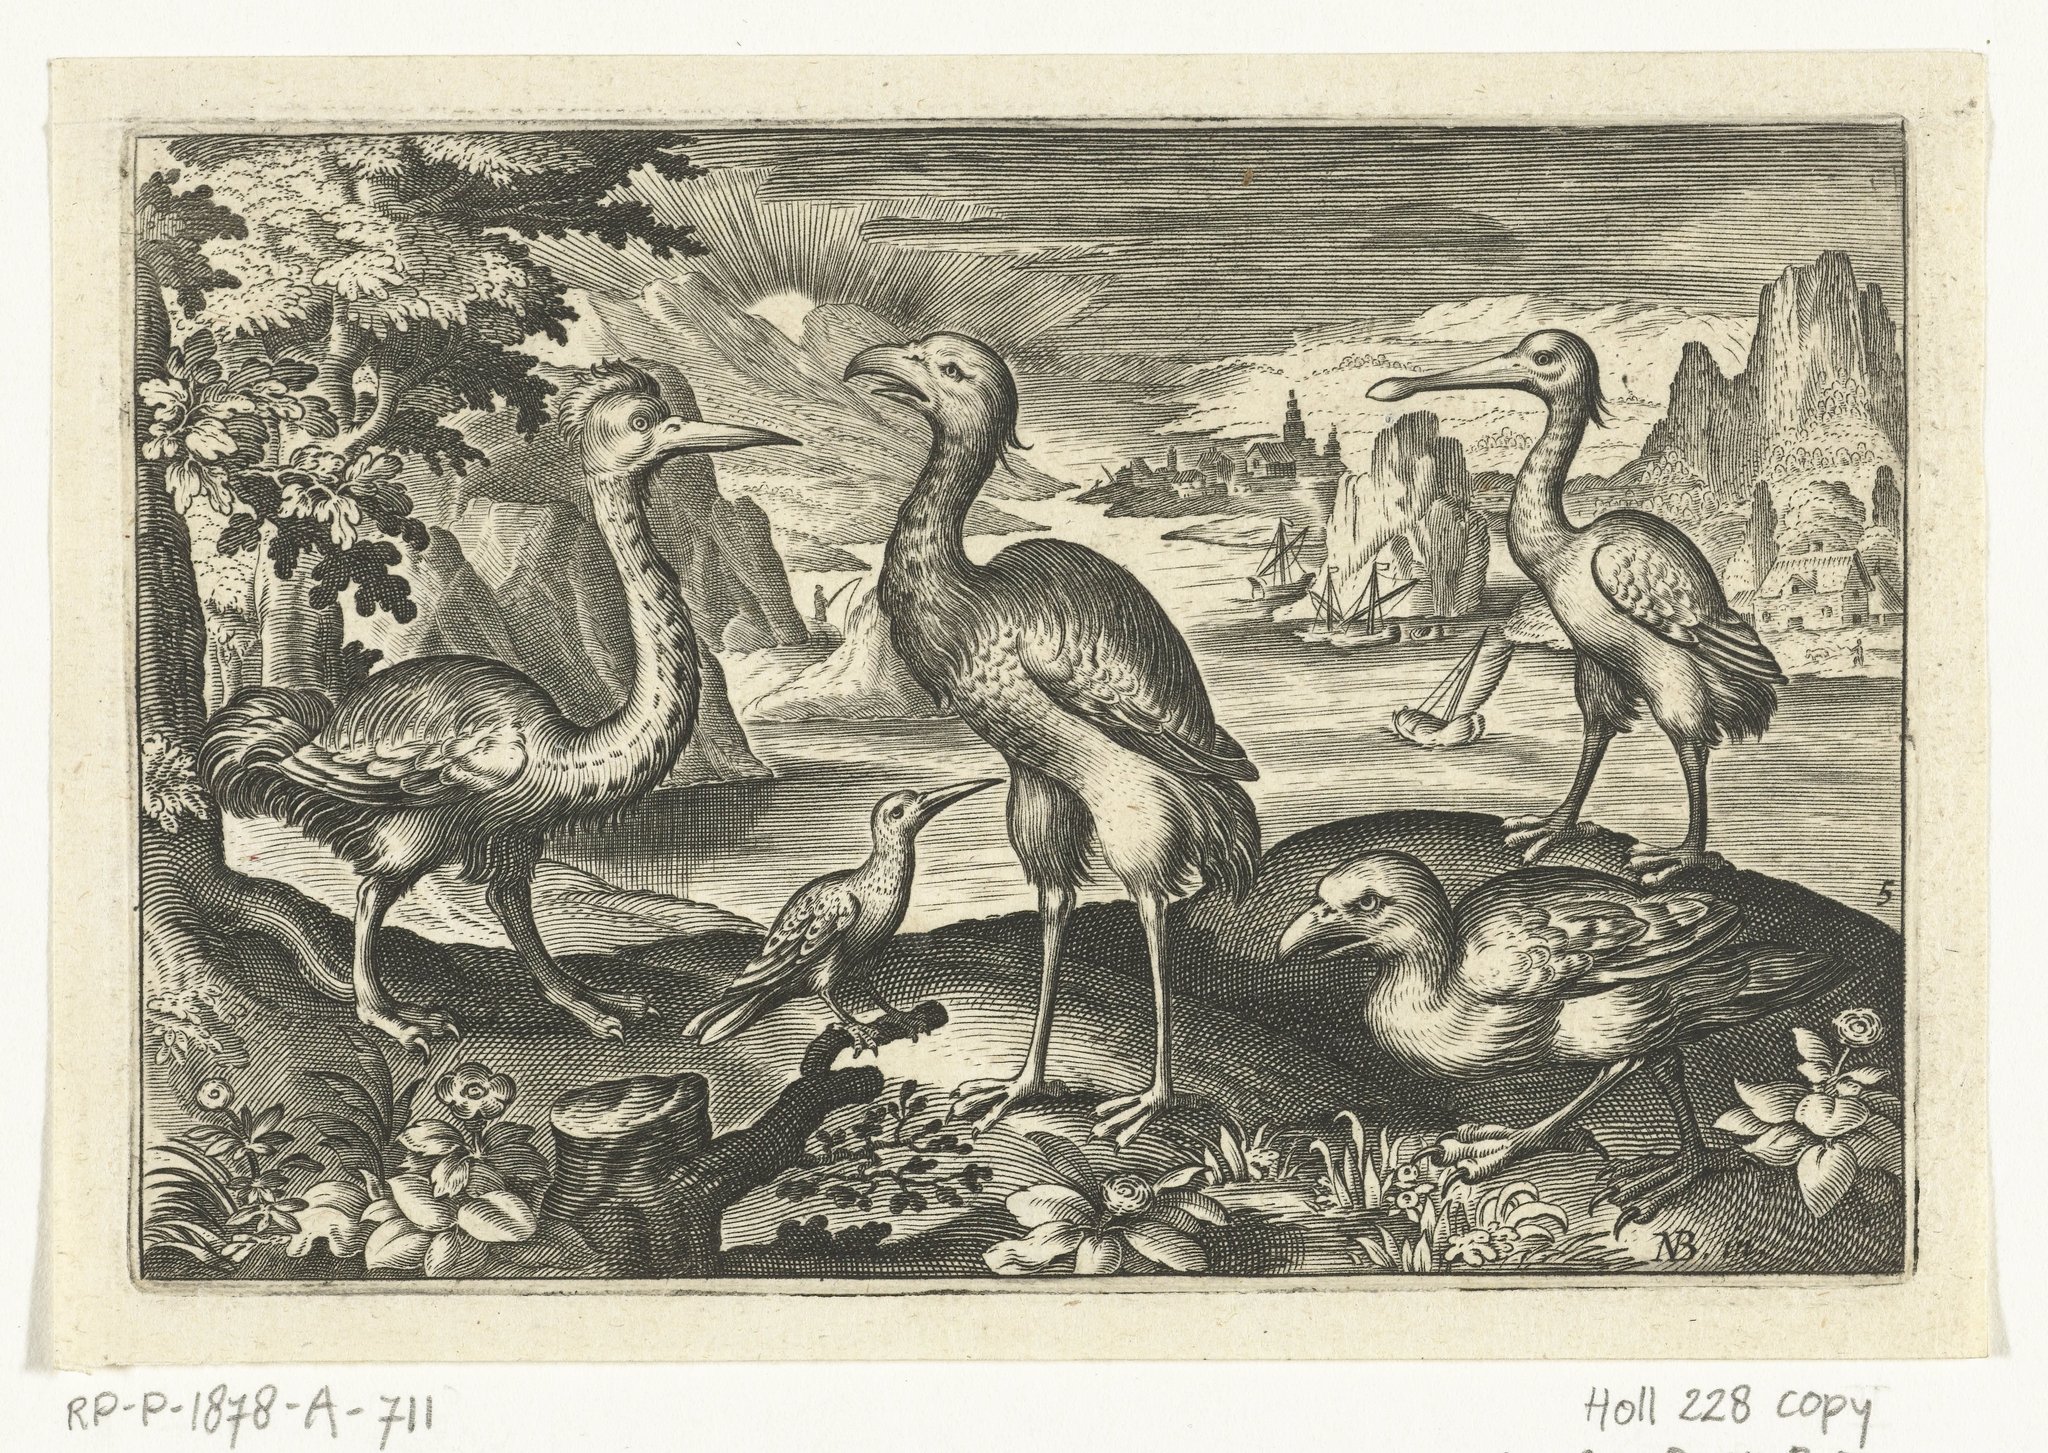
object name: print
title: Vogels en insecten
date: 1594-1644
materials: paper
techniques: engraving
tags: shore-birds and wading-birds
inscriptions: collector's mark: Lugt 2228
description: Kopie naar prent van Nicolaes de Bruyn. Prent uit serie van twaalf prenten met vogels en insecten. Bij Hollstein zijn bladen van een andere serie prenten afgebeeld, zie De Groot 1988, p. 37.